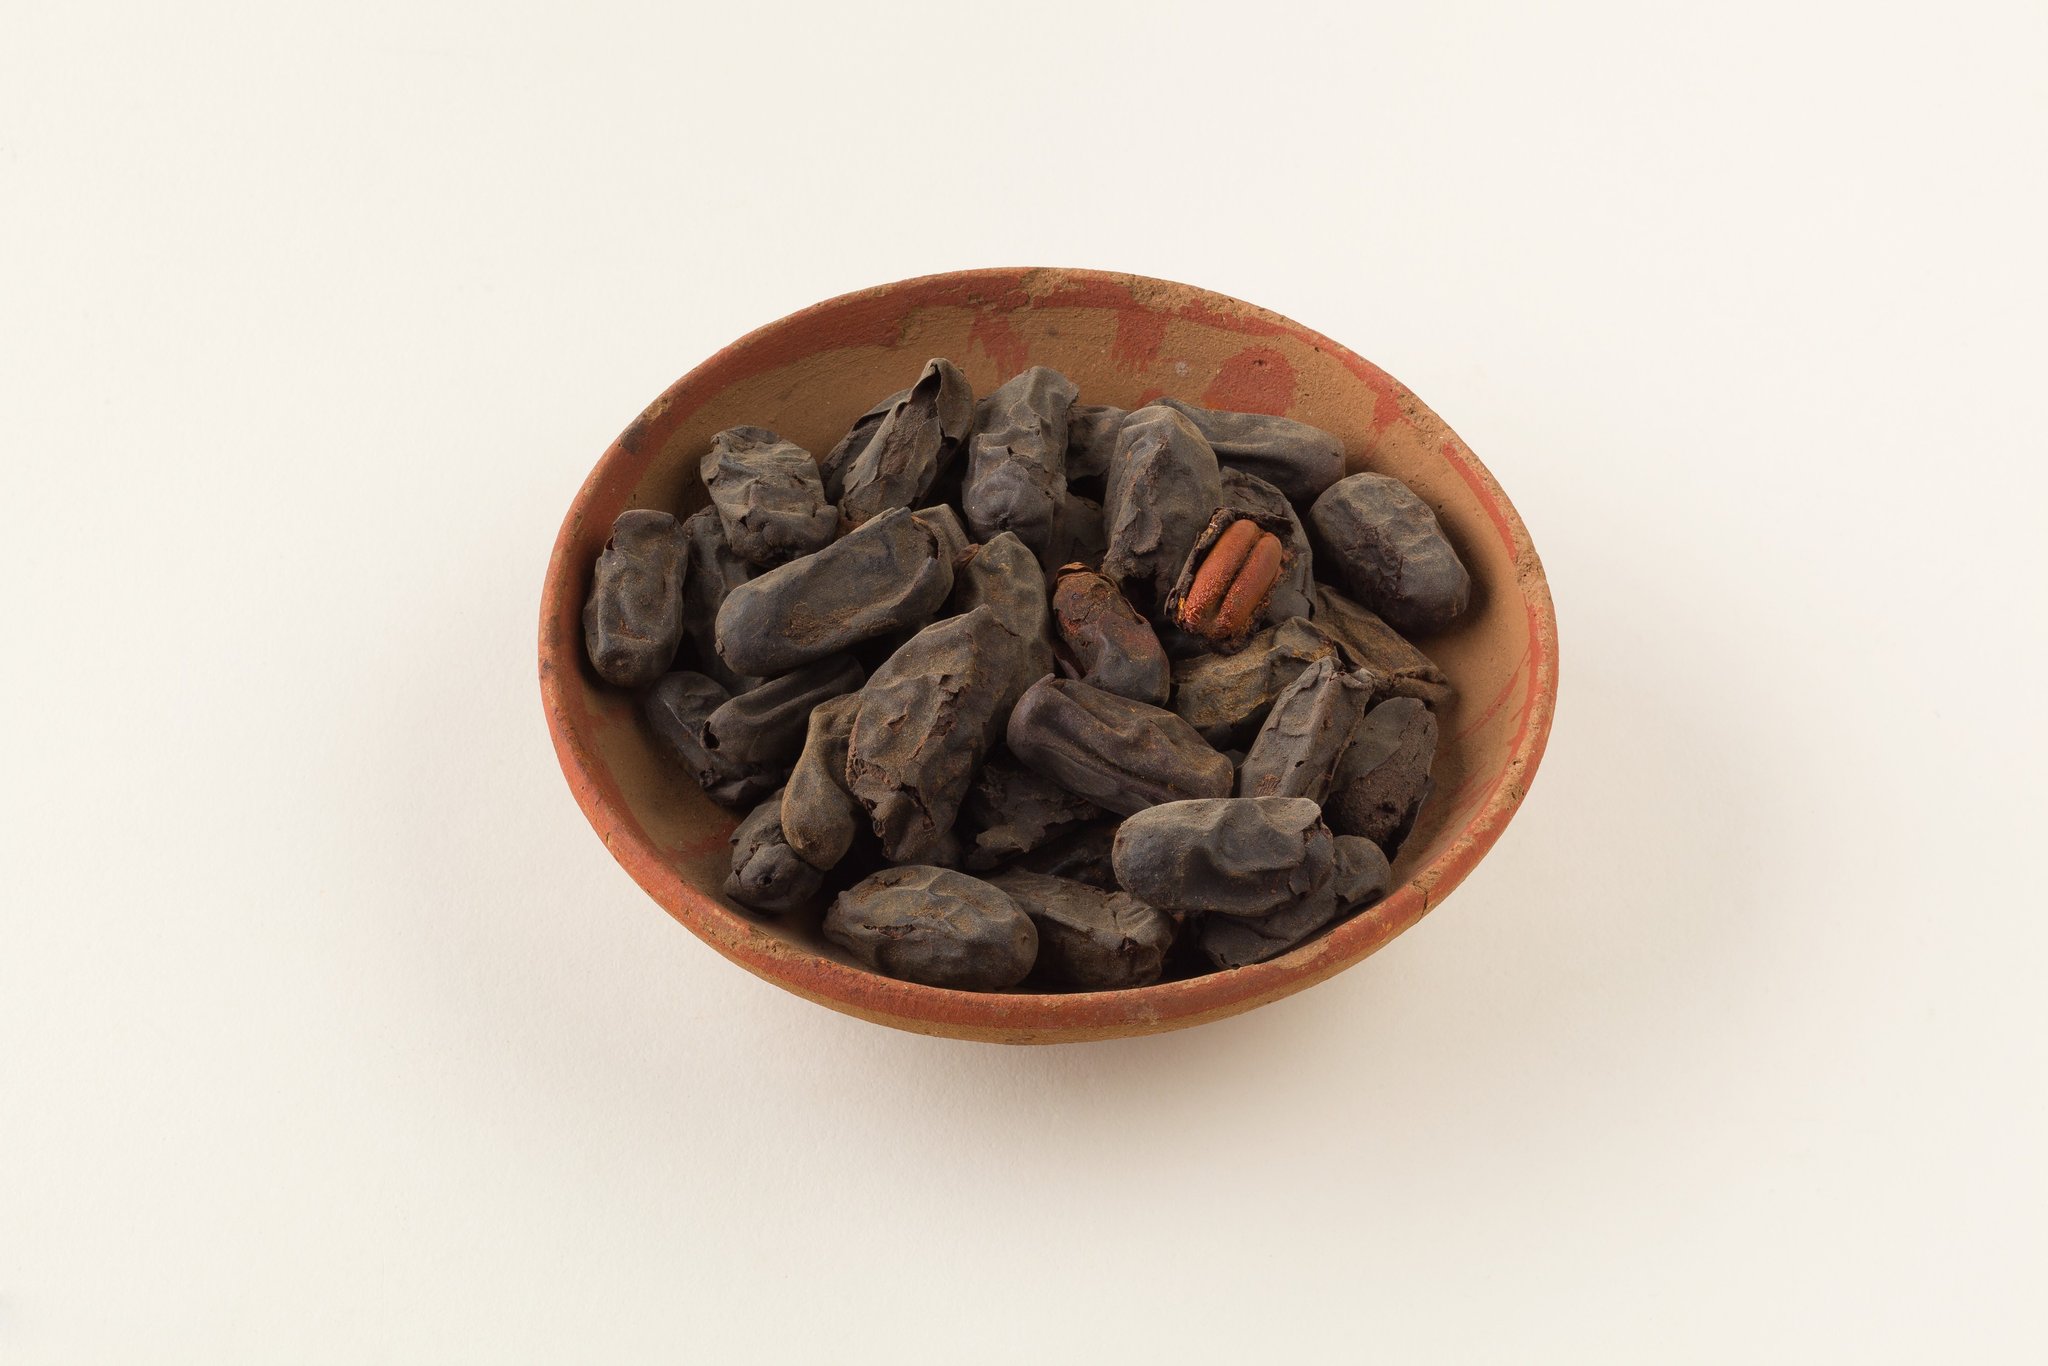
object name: dish, decorated, date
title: Dish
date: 1492-1473 BCE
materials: pottery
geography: egypt